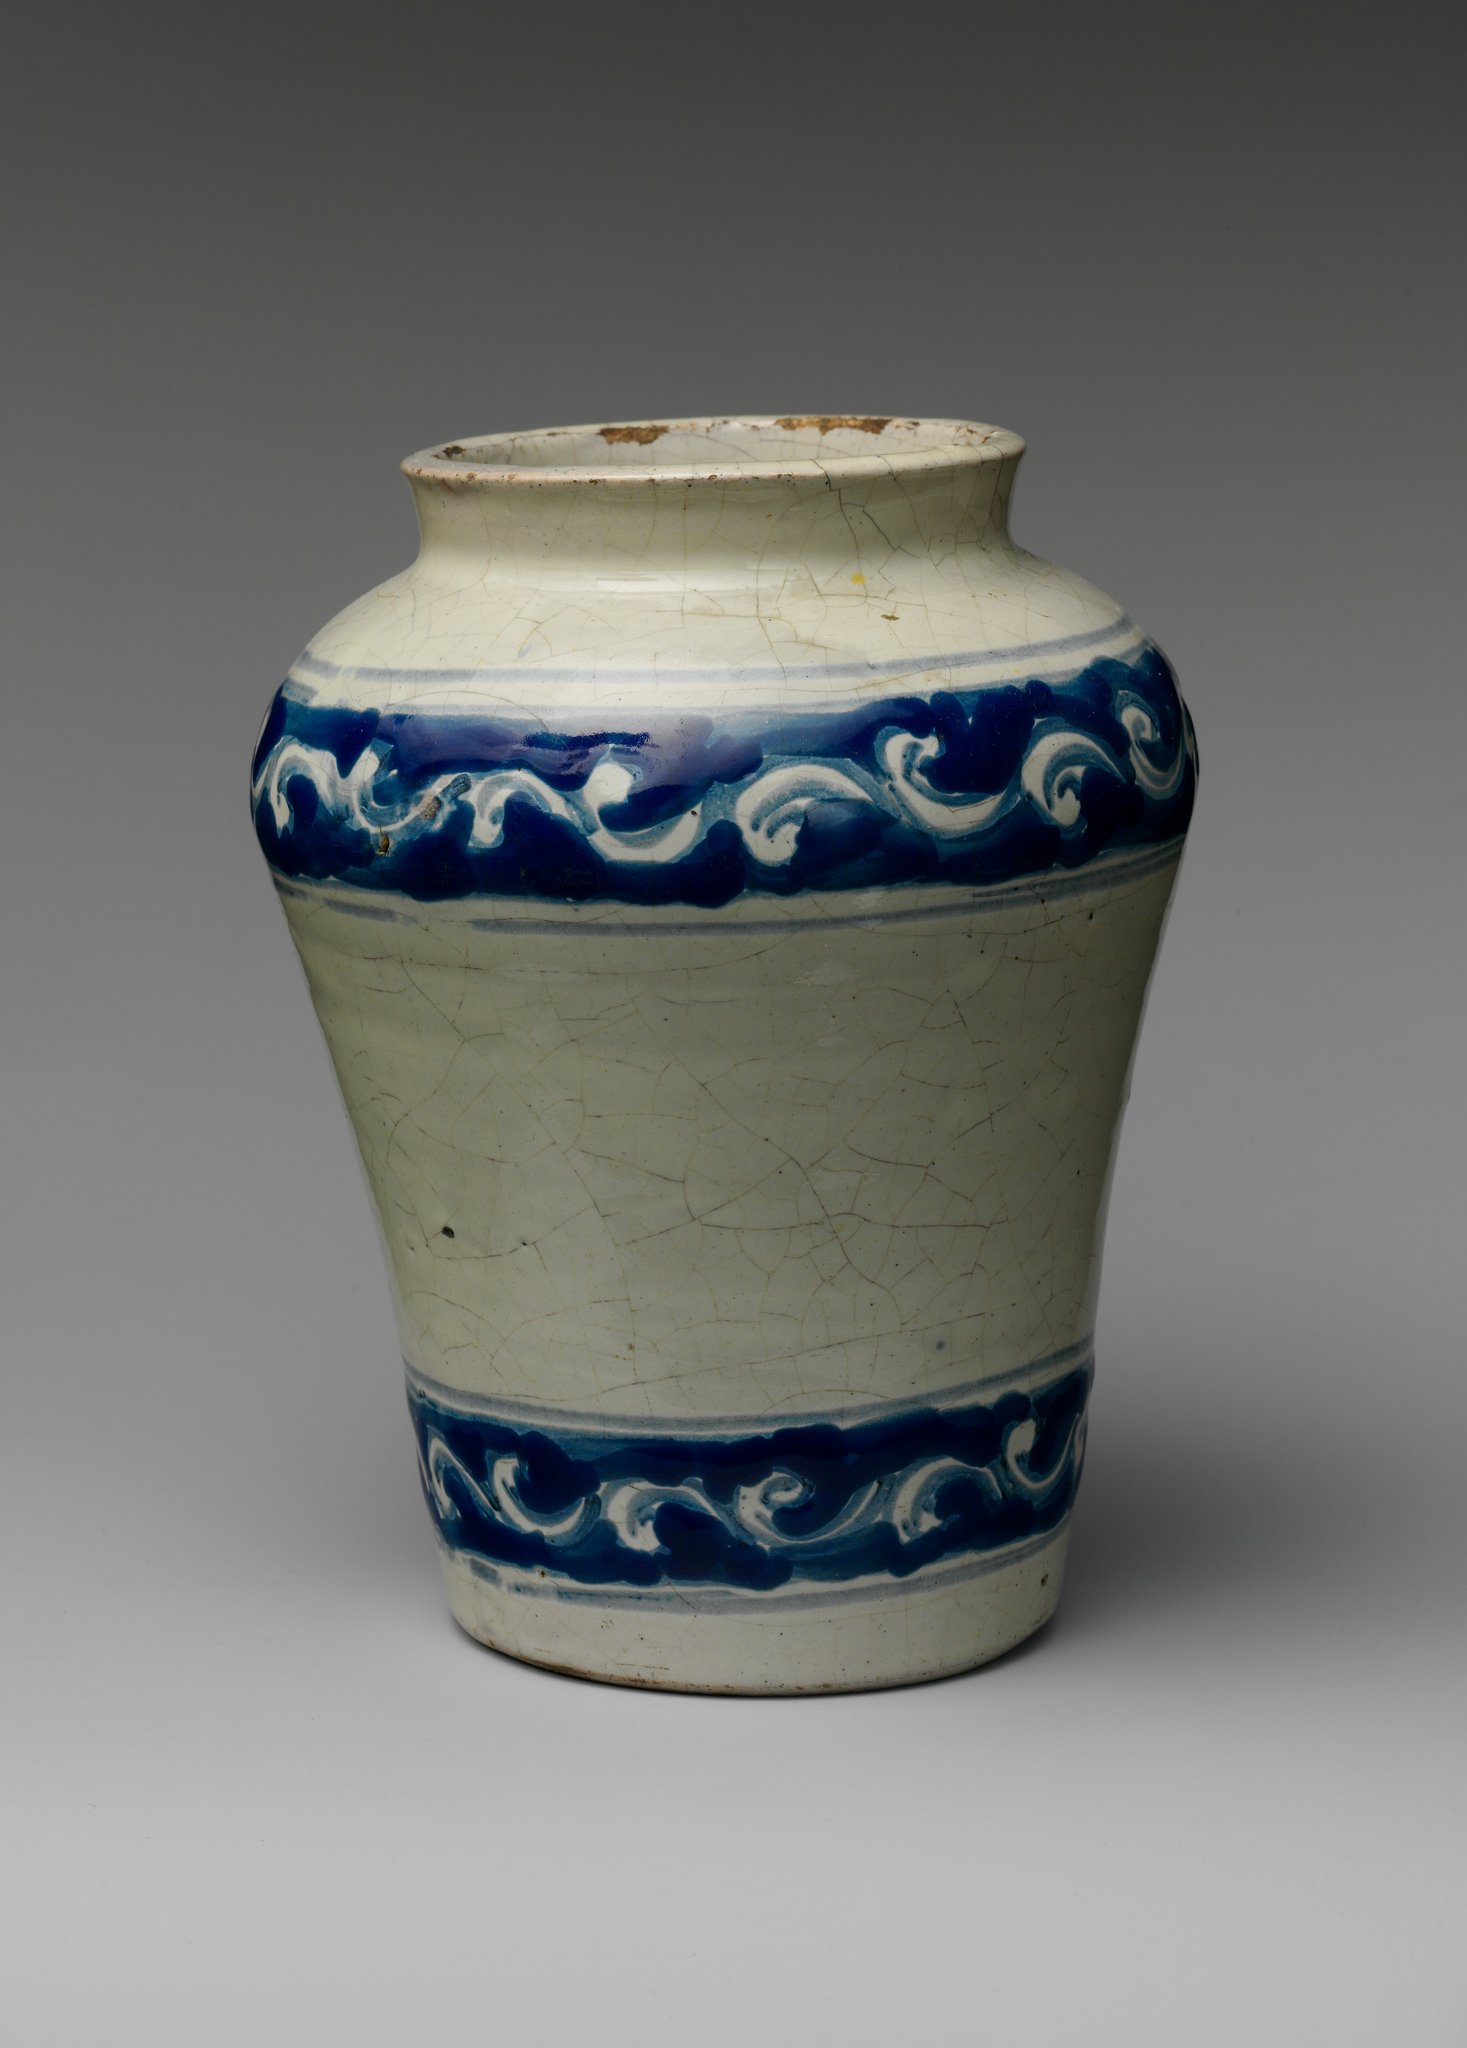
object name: jar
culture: mexican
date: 1750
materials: earthenware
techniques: glazing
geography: mexico